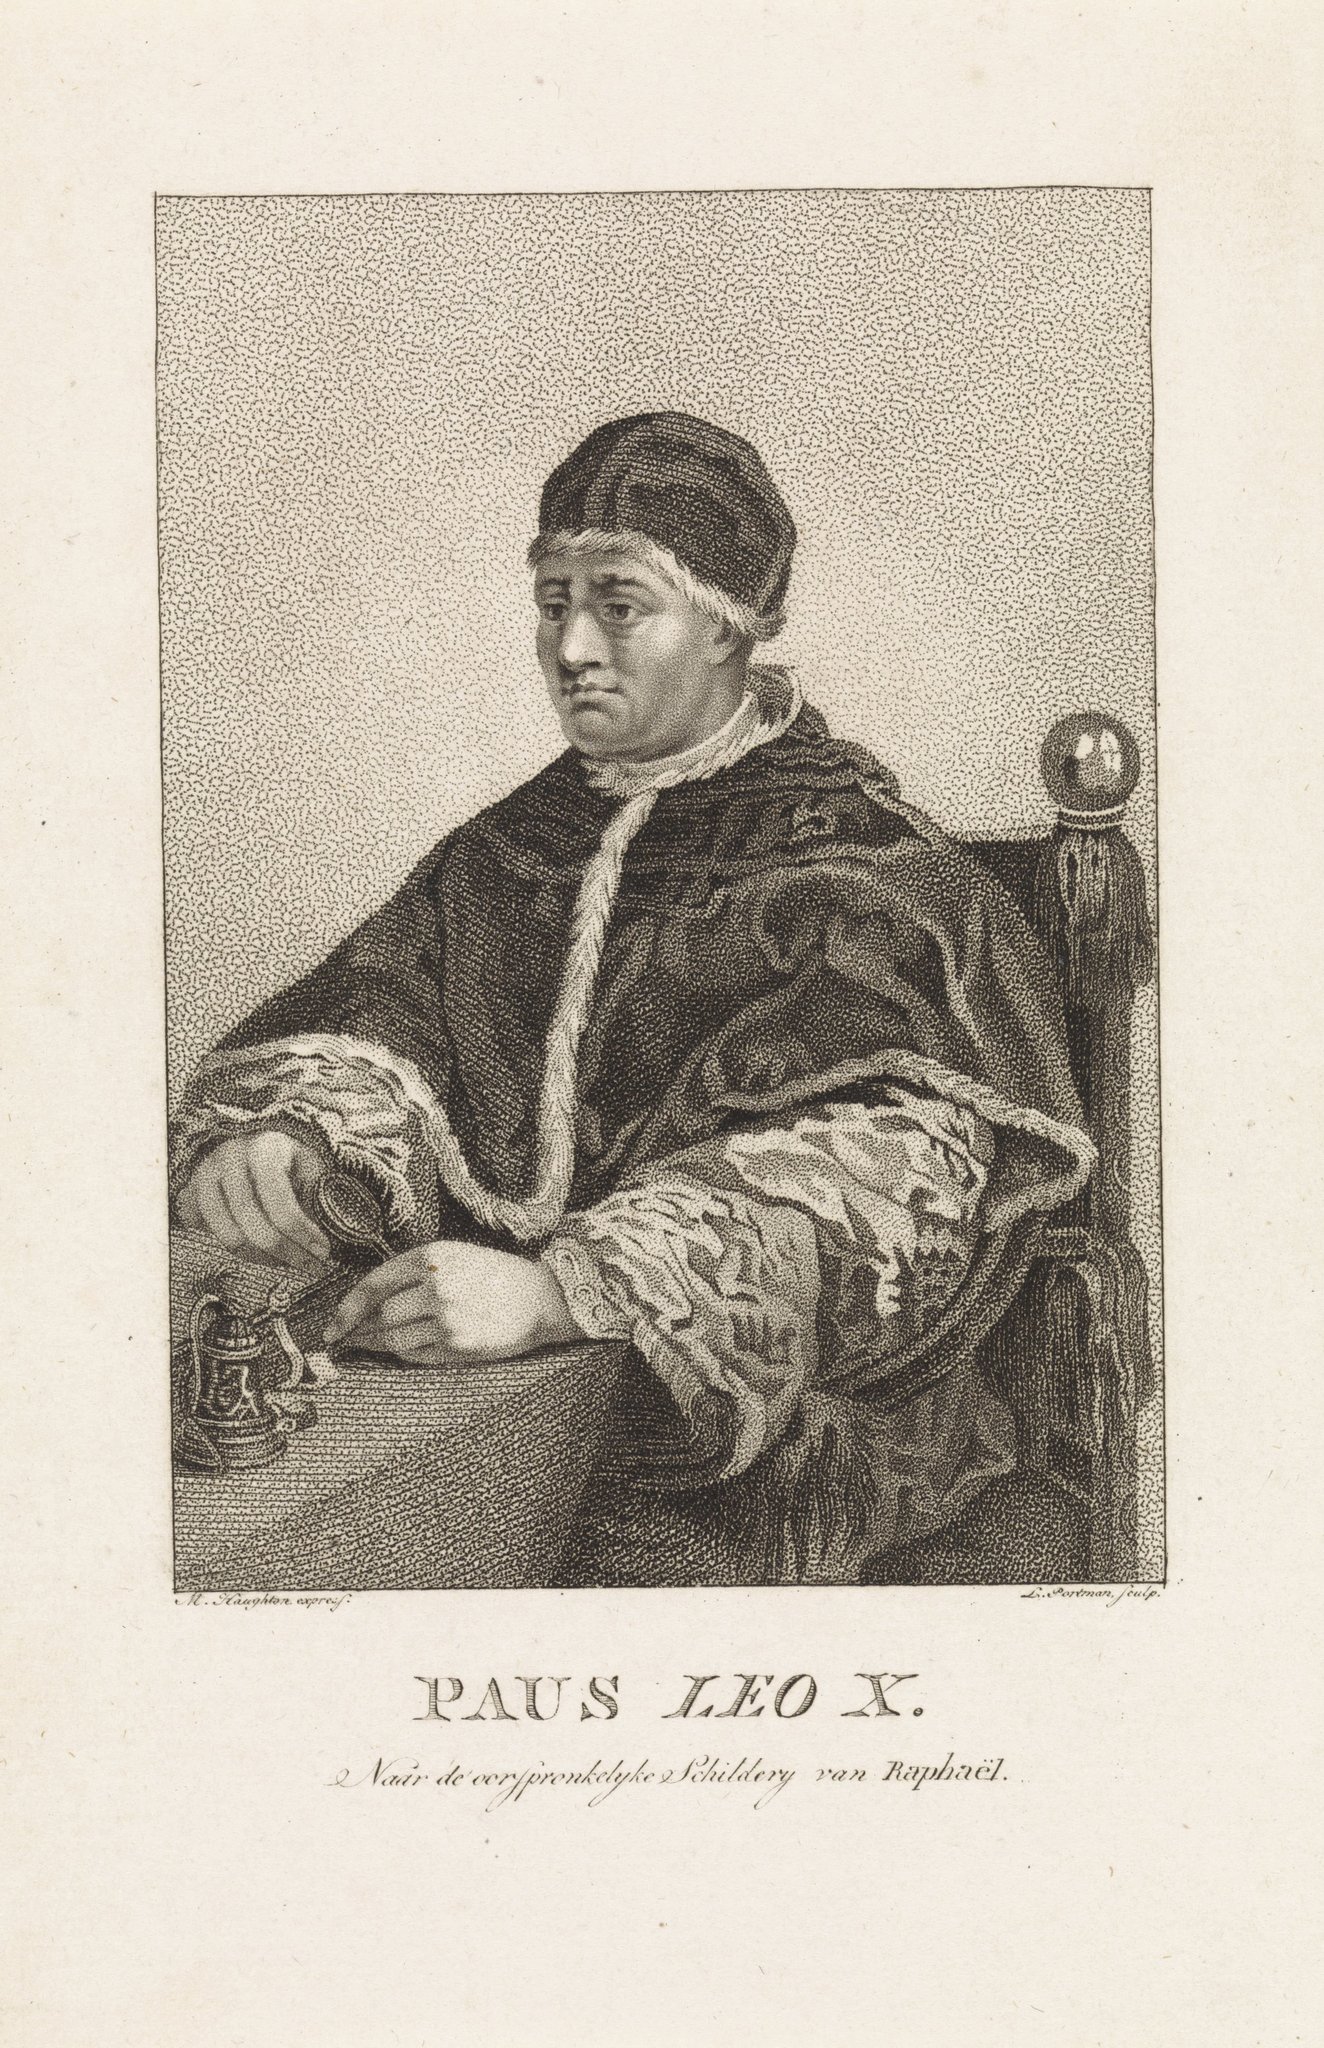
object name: print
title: Portret van paus Leo X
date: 1787-1828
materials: paper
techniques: stippled etching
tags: leo x, bell ~ musical instruments, magnifying glass, the bible as a book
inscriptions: collector's mark: Lugt 2228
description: Paus Leo X zit aan een tafel en bladert door een bijbel. In zijn hand houdt hij een loep om het boek te bestuderen. Op de tafel staat een bel.